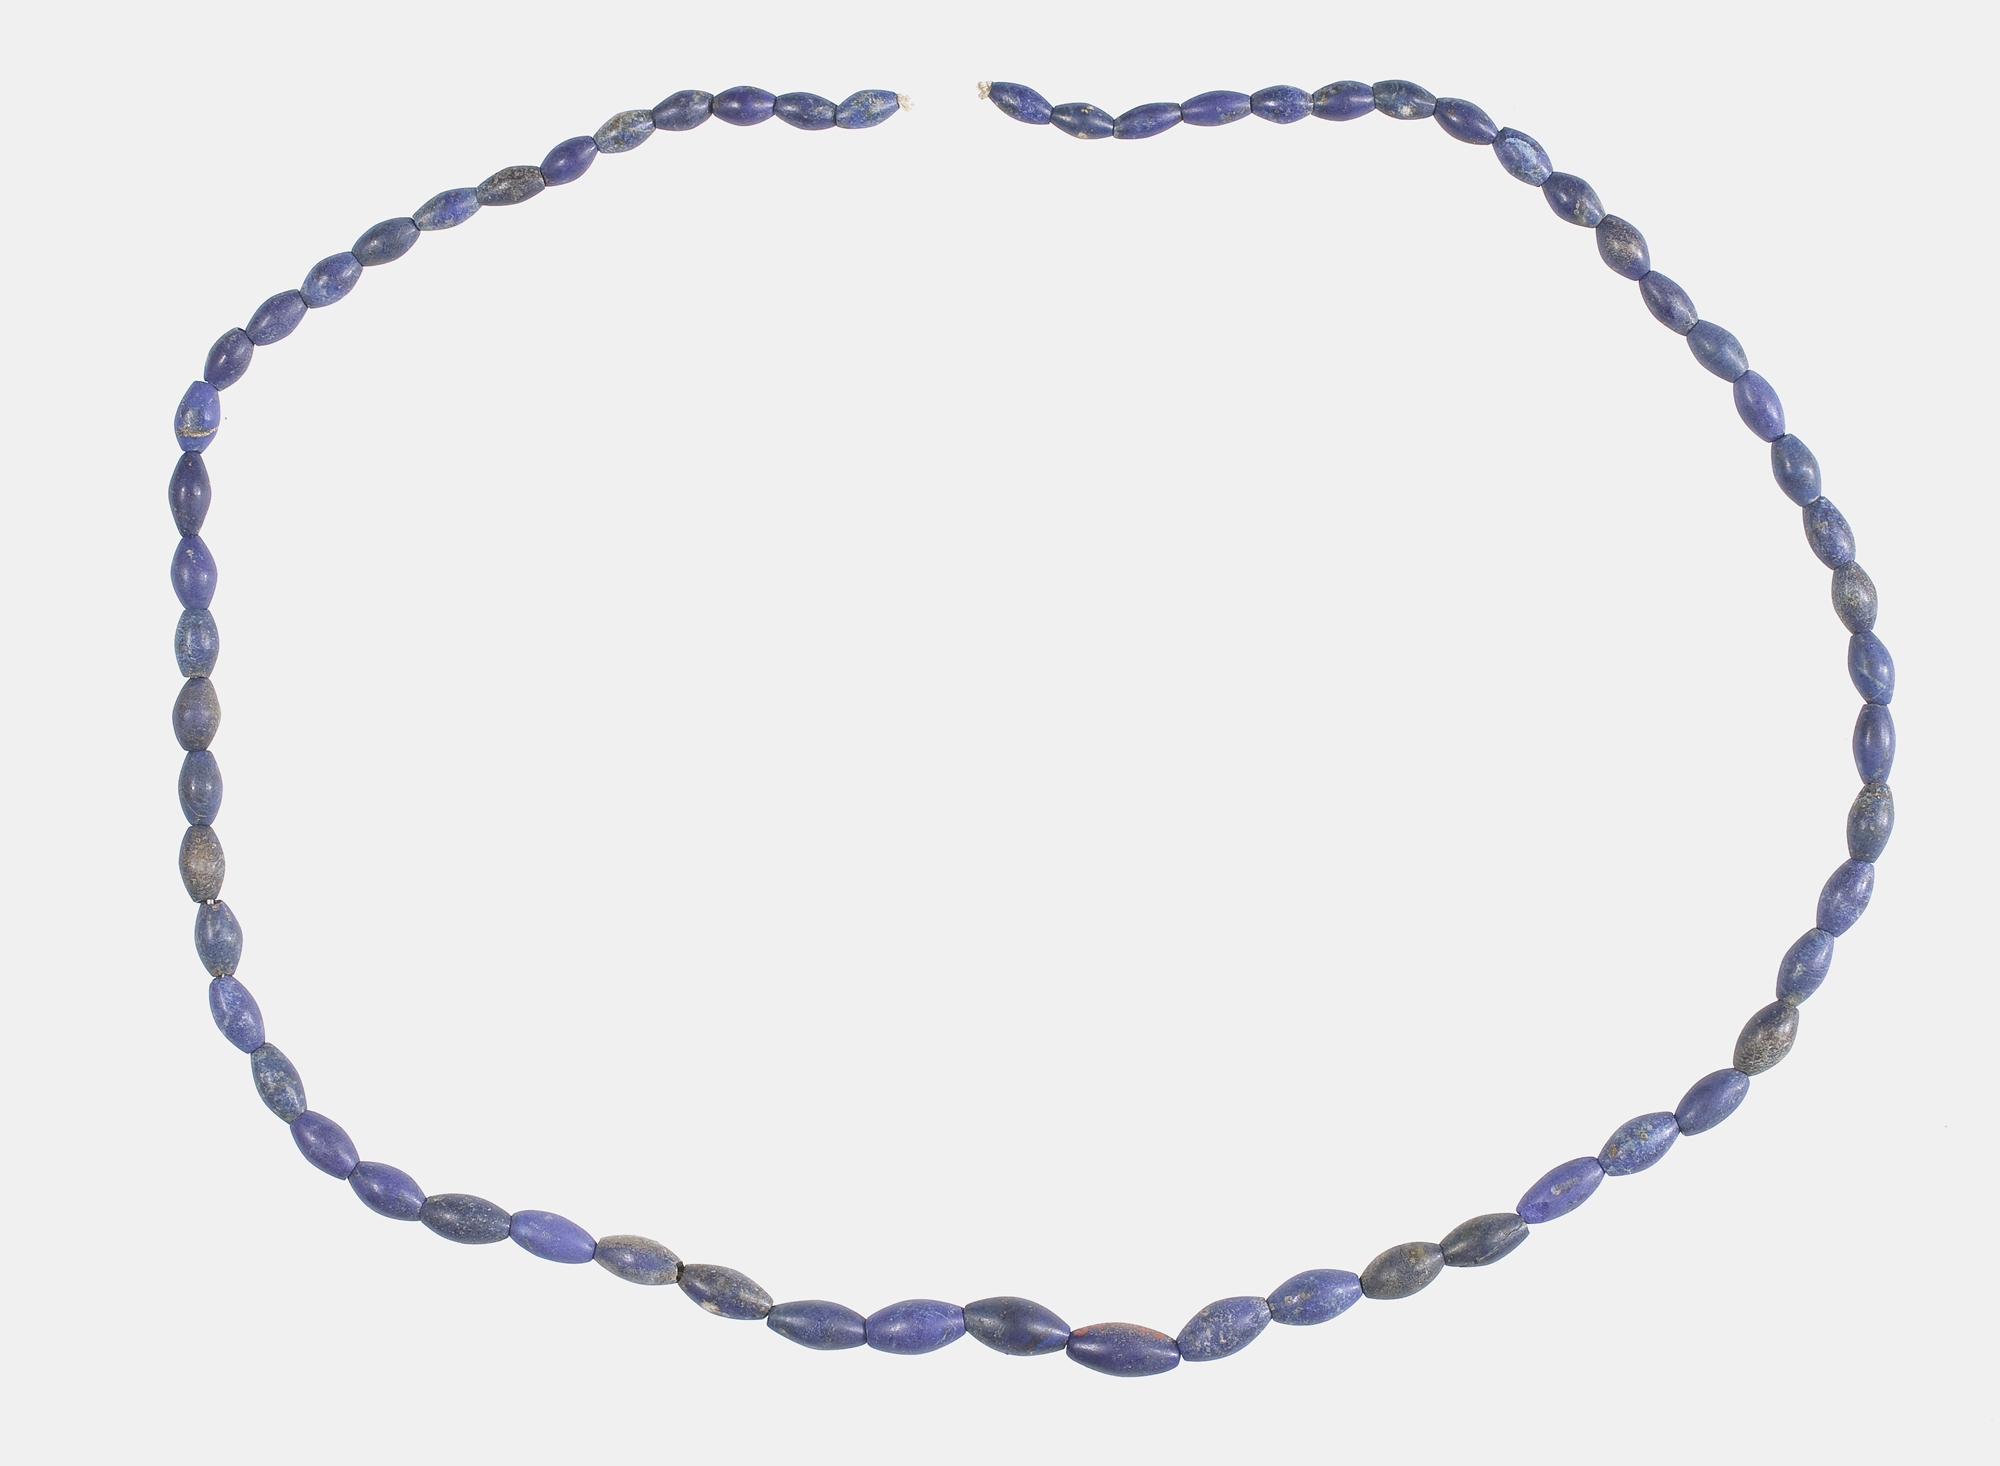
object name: bead, string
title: Hepy, String of beads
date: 1950-1885 BCE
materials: lapis lazuli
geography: egypt